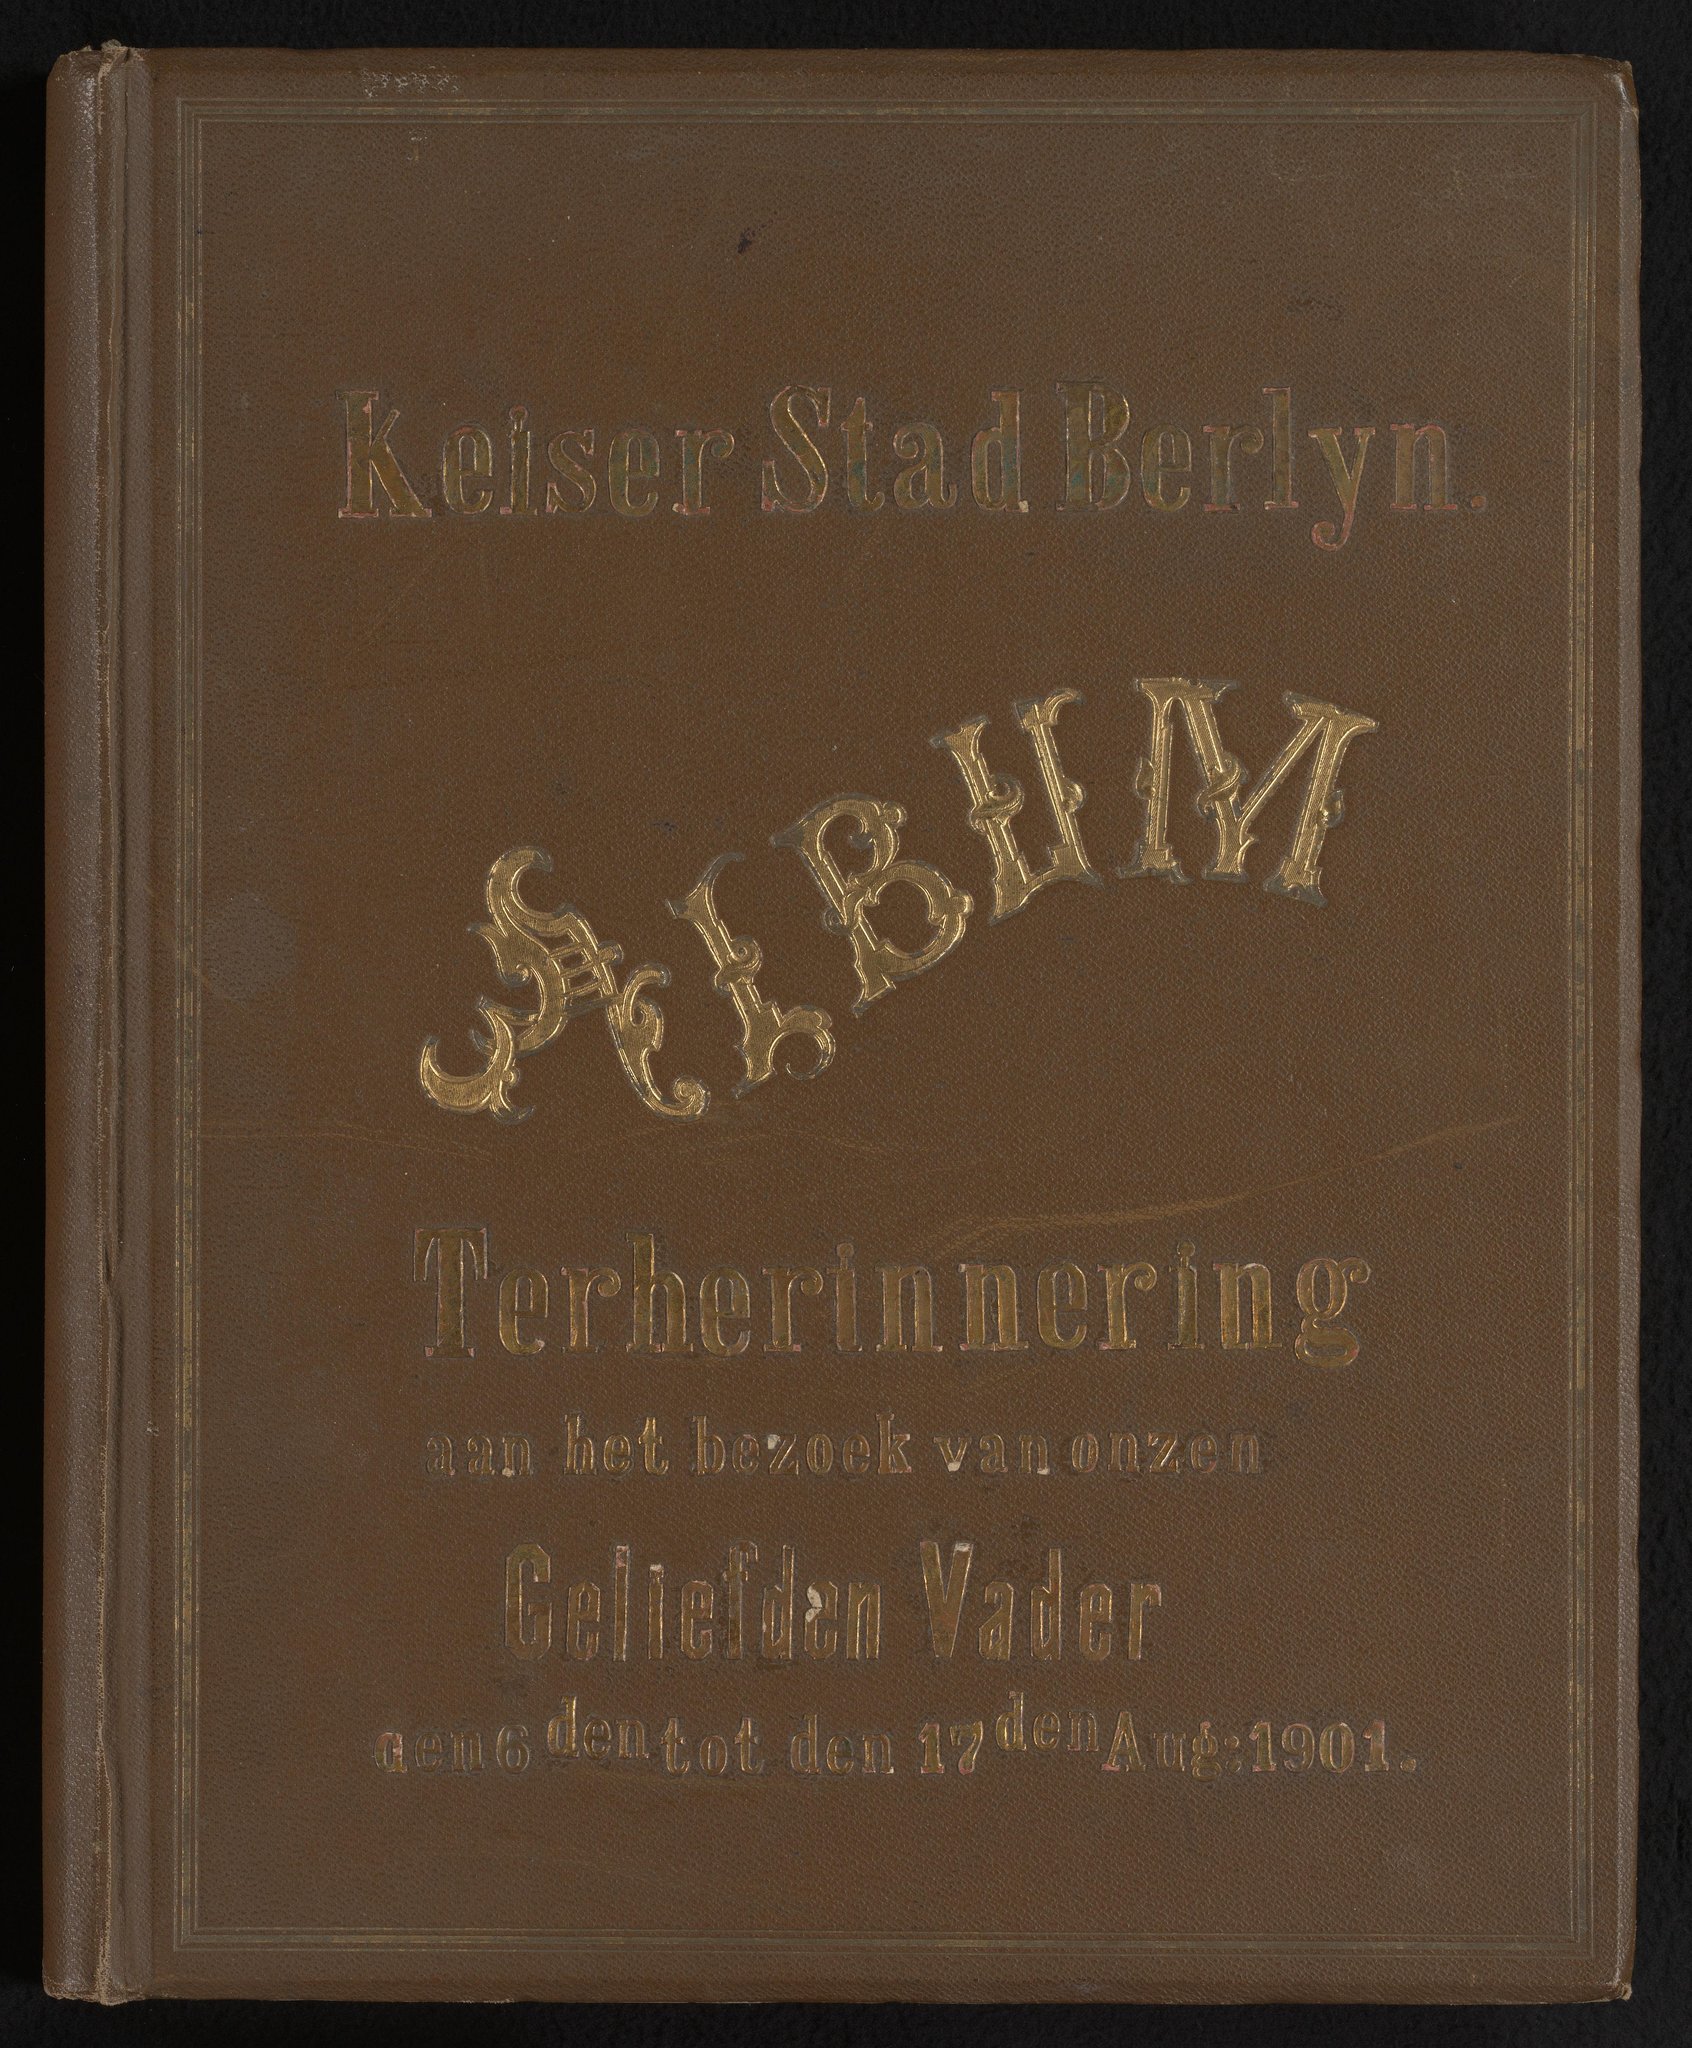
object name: scrapbook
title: Fotoalbum ter herinnering aan een reis naar Berlijn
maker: Anonymous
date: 1901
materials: paper, cardboard, leather, photographic process, plant material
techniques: photograph, writing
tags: berlin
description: Fotoalbum met 135 foto's en fotomechanische afdrukken van stadsgezichten en straatbeelden in Berlijn, beroemde gebouwen aldaar en personen van het Duitse keizerlijk hof.